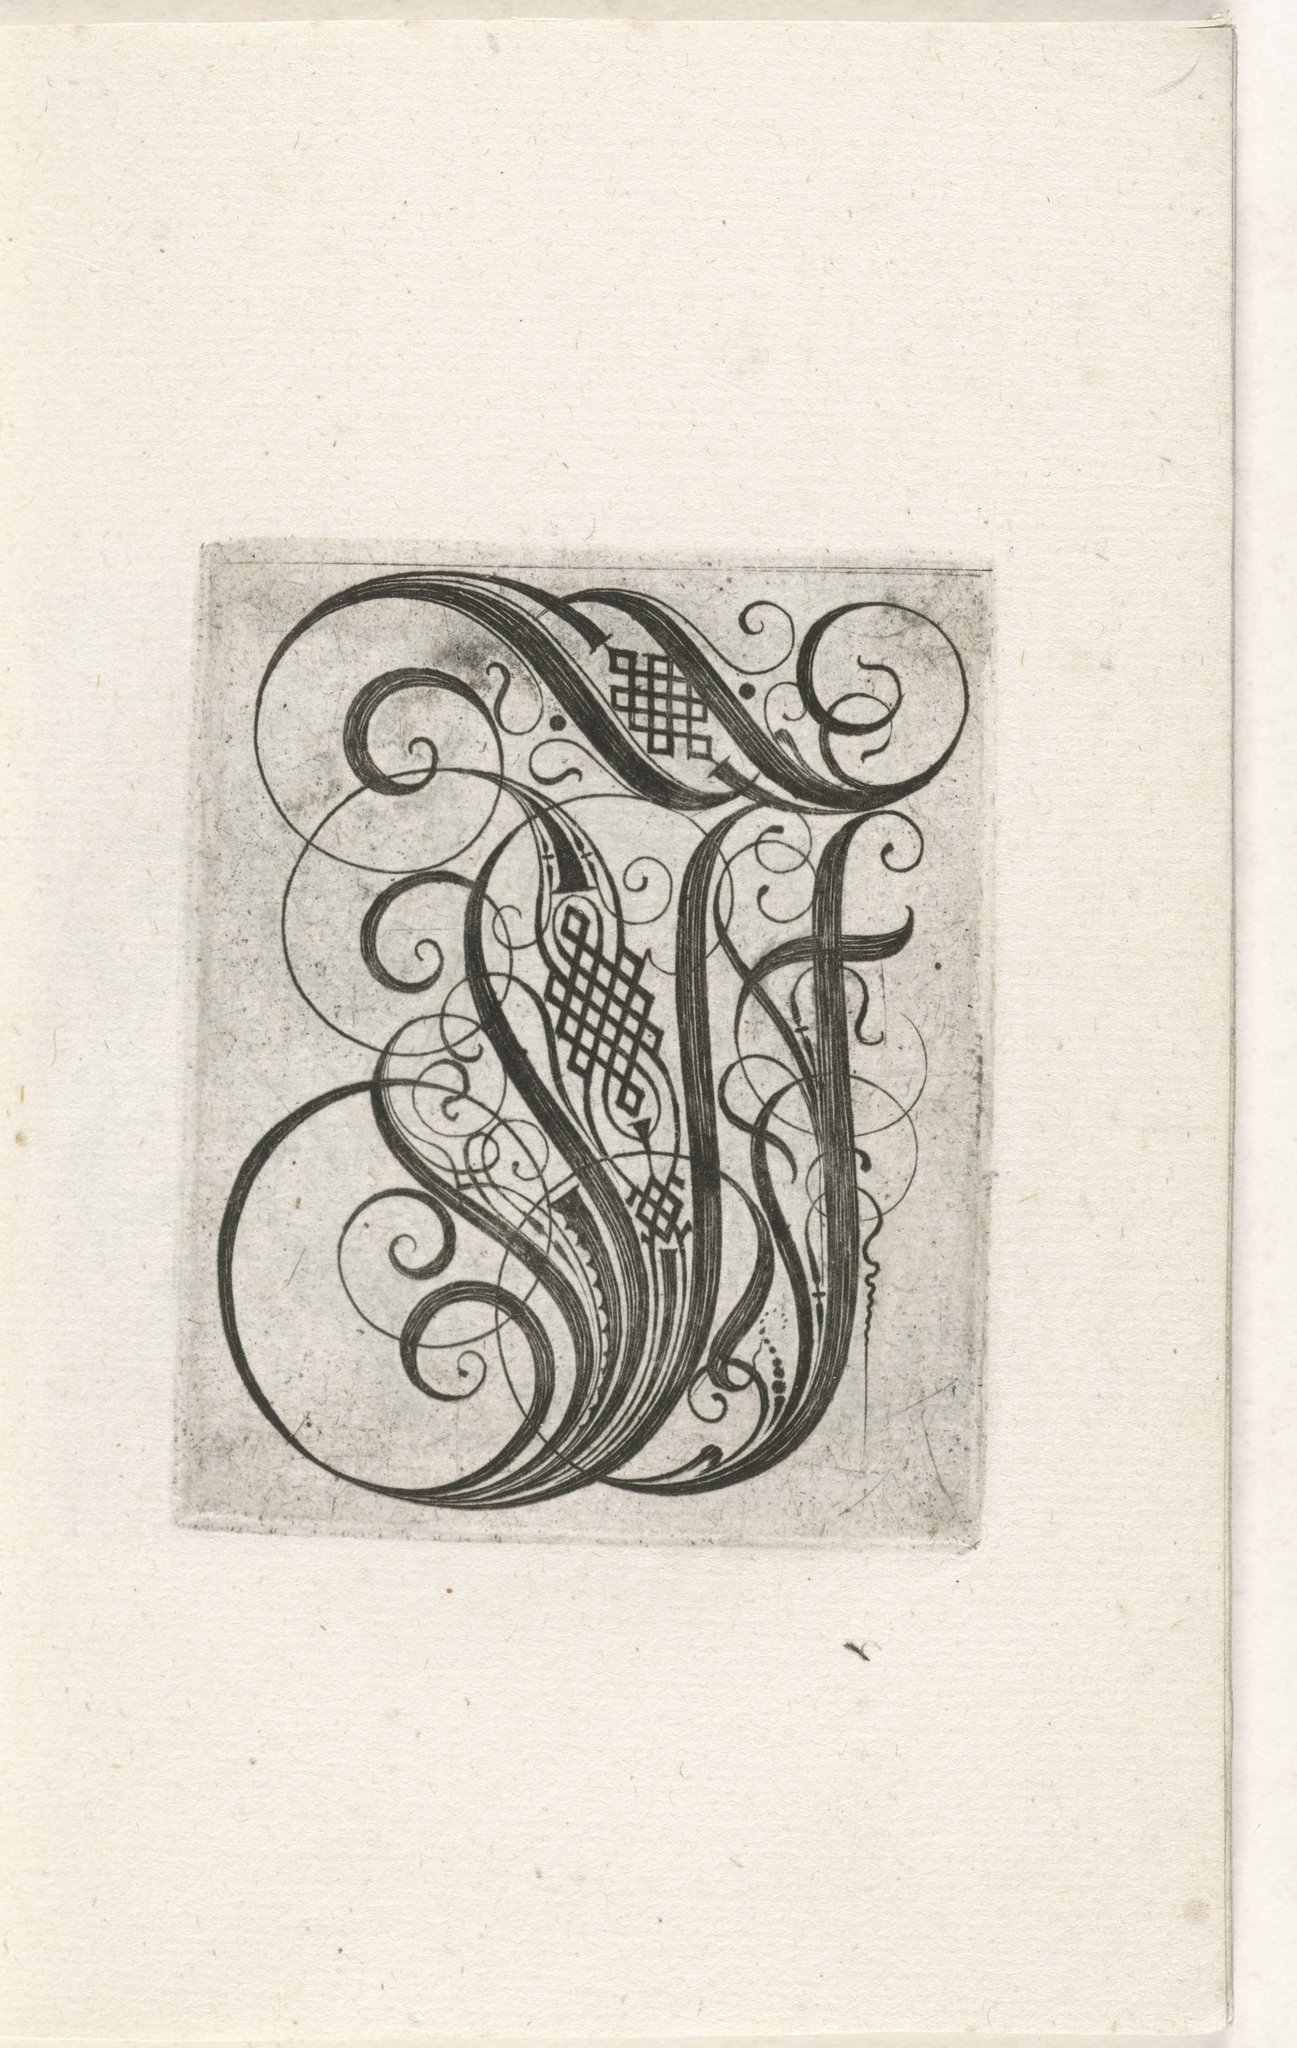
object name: print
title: Alfabet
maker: Anonymous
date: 1600-1699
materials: paper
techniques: engraving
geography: netherlands